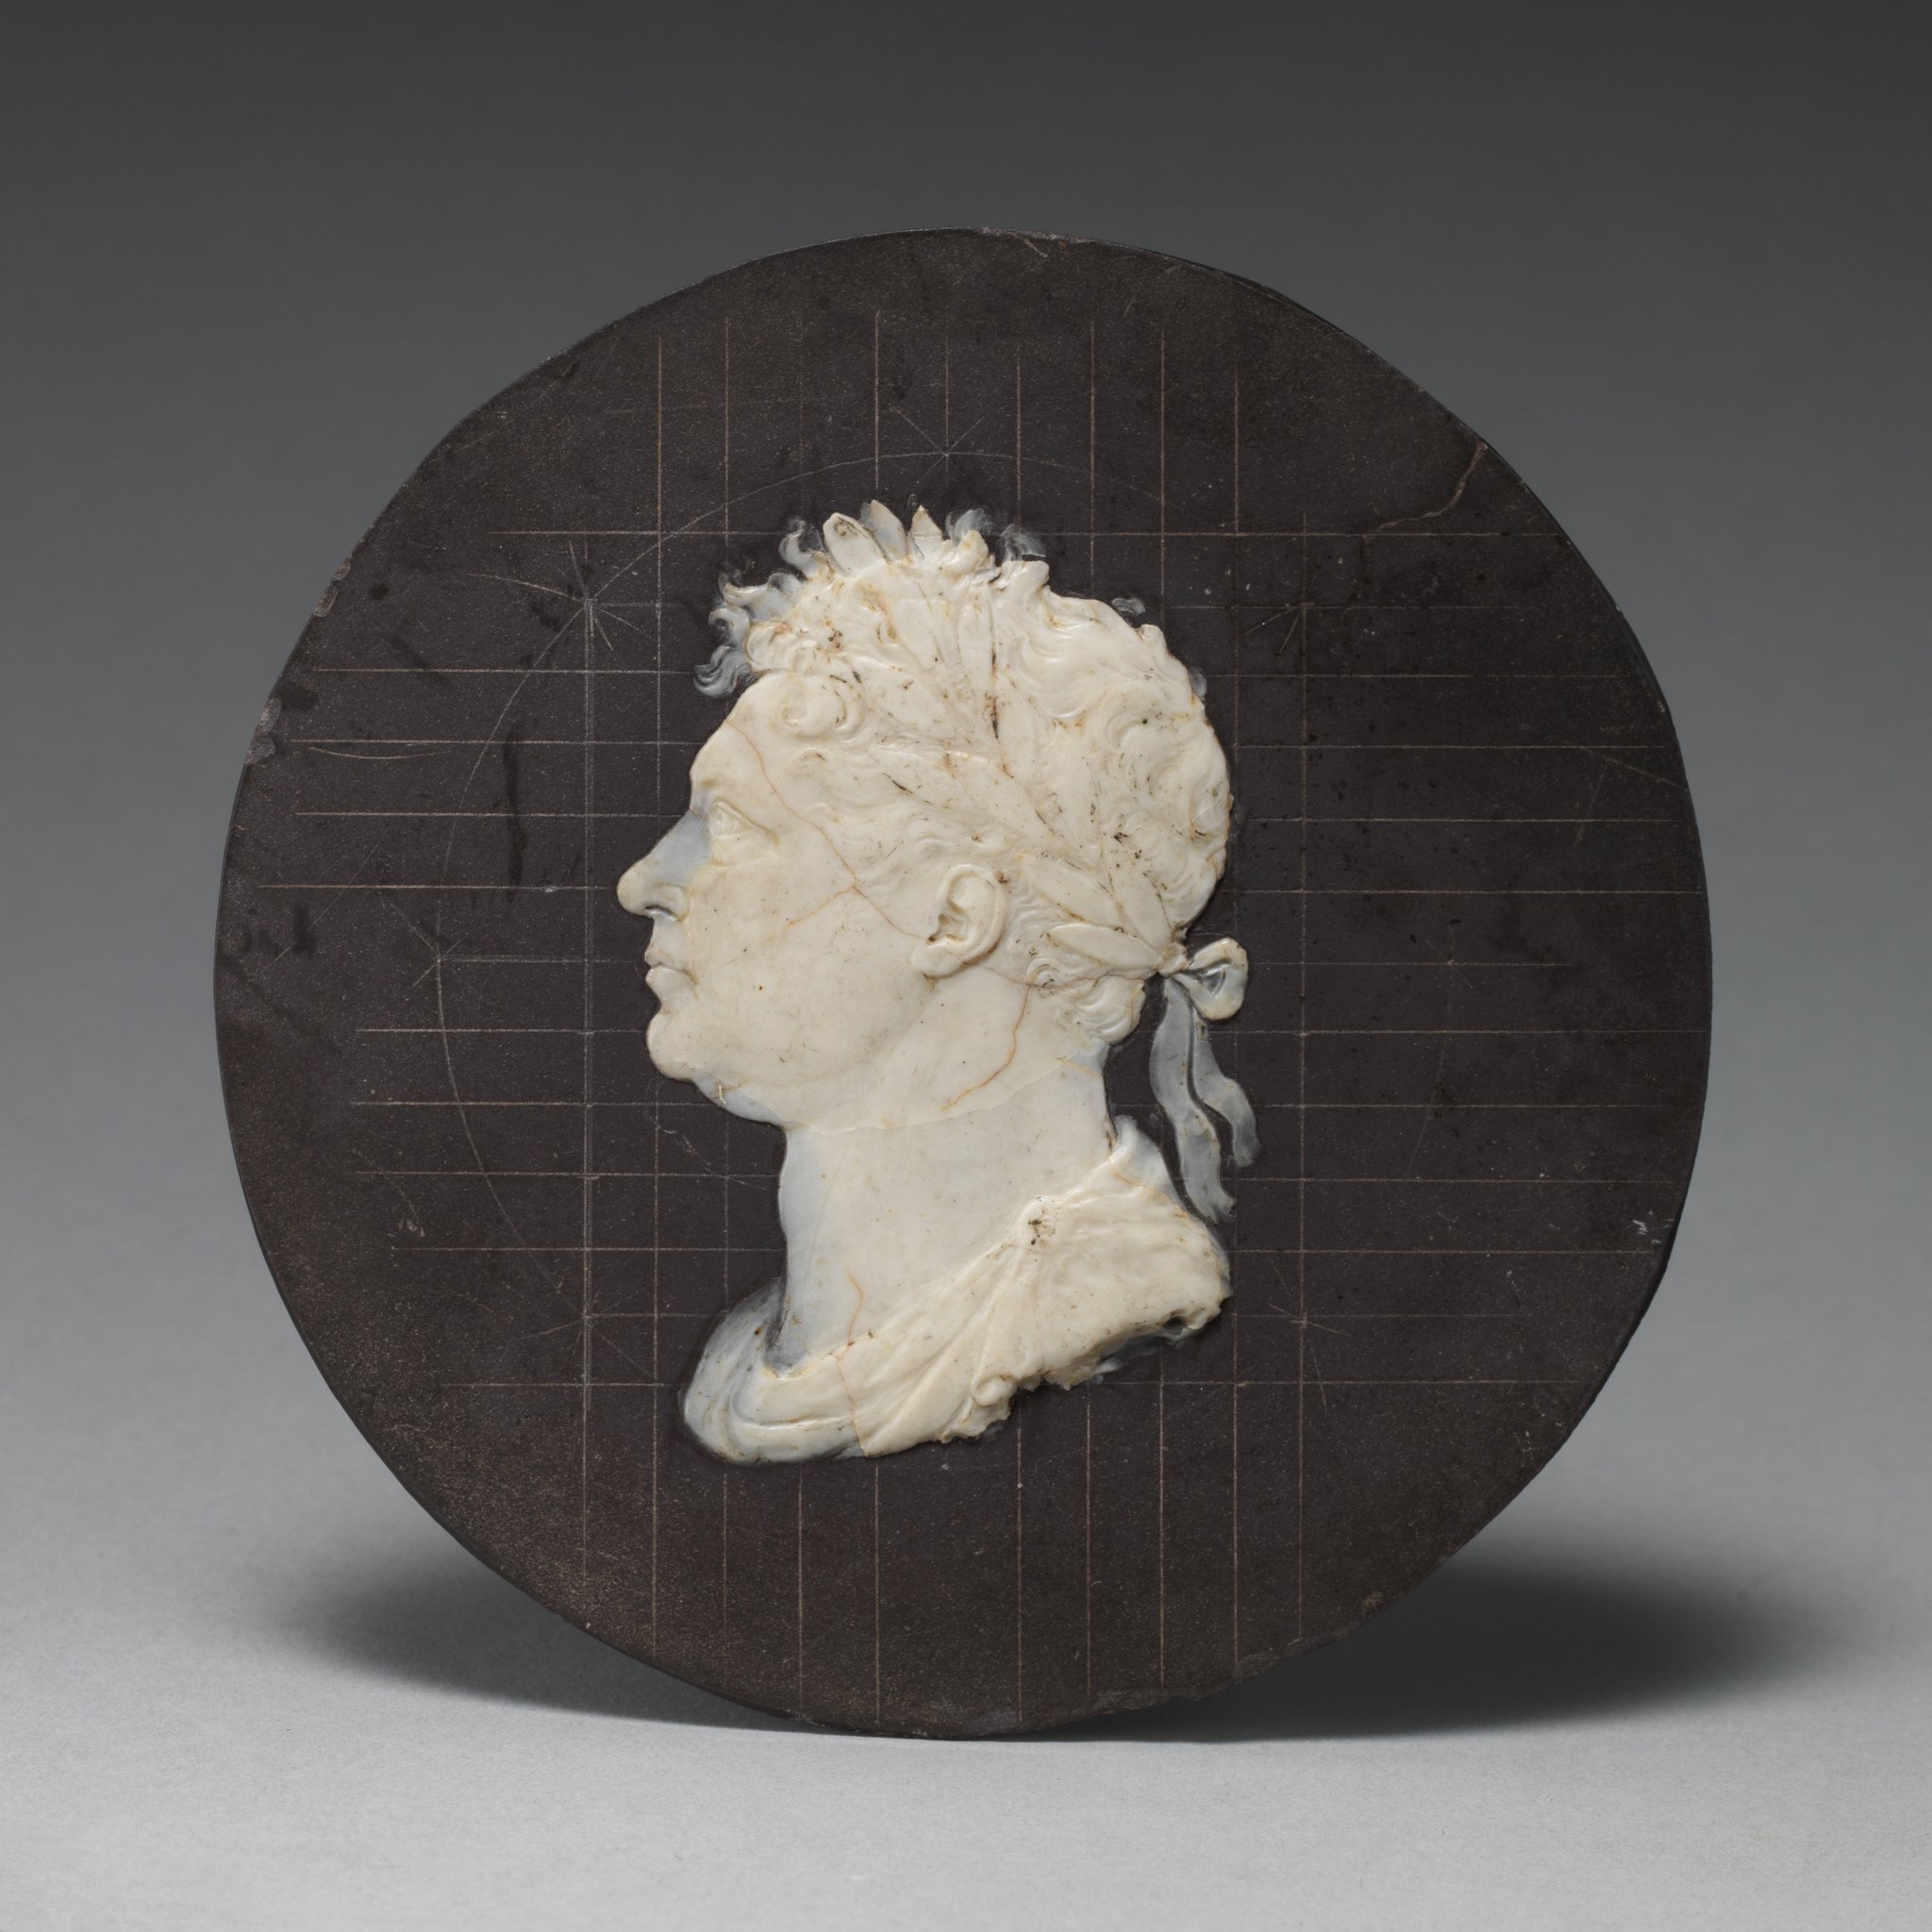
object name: wax model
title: Wax model for a portrait of King George IV (1762–1830)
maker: benedetto pistrucci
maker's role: maker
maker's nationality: italian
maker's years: 1783-1855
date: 1820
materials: wax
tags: profiles